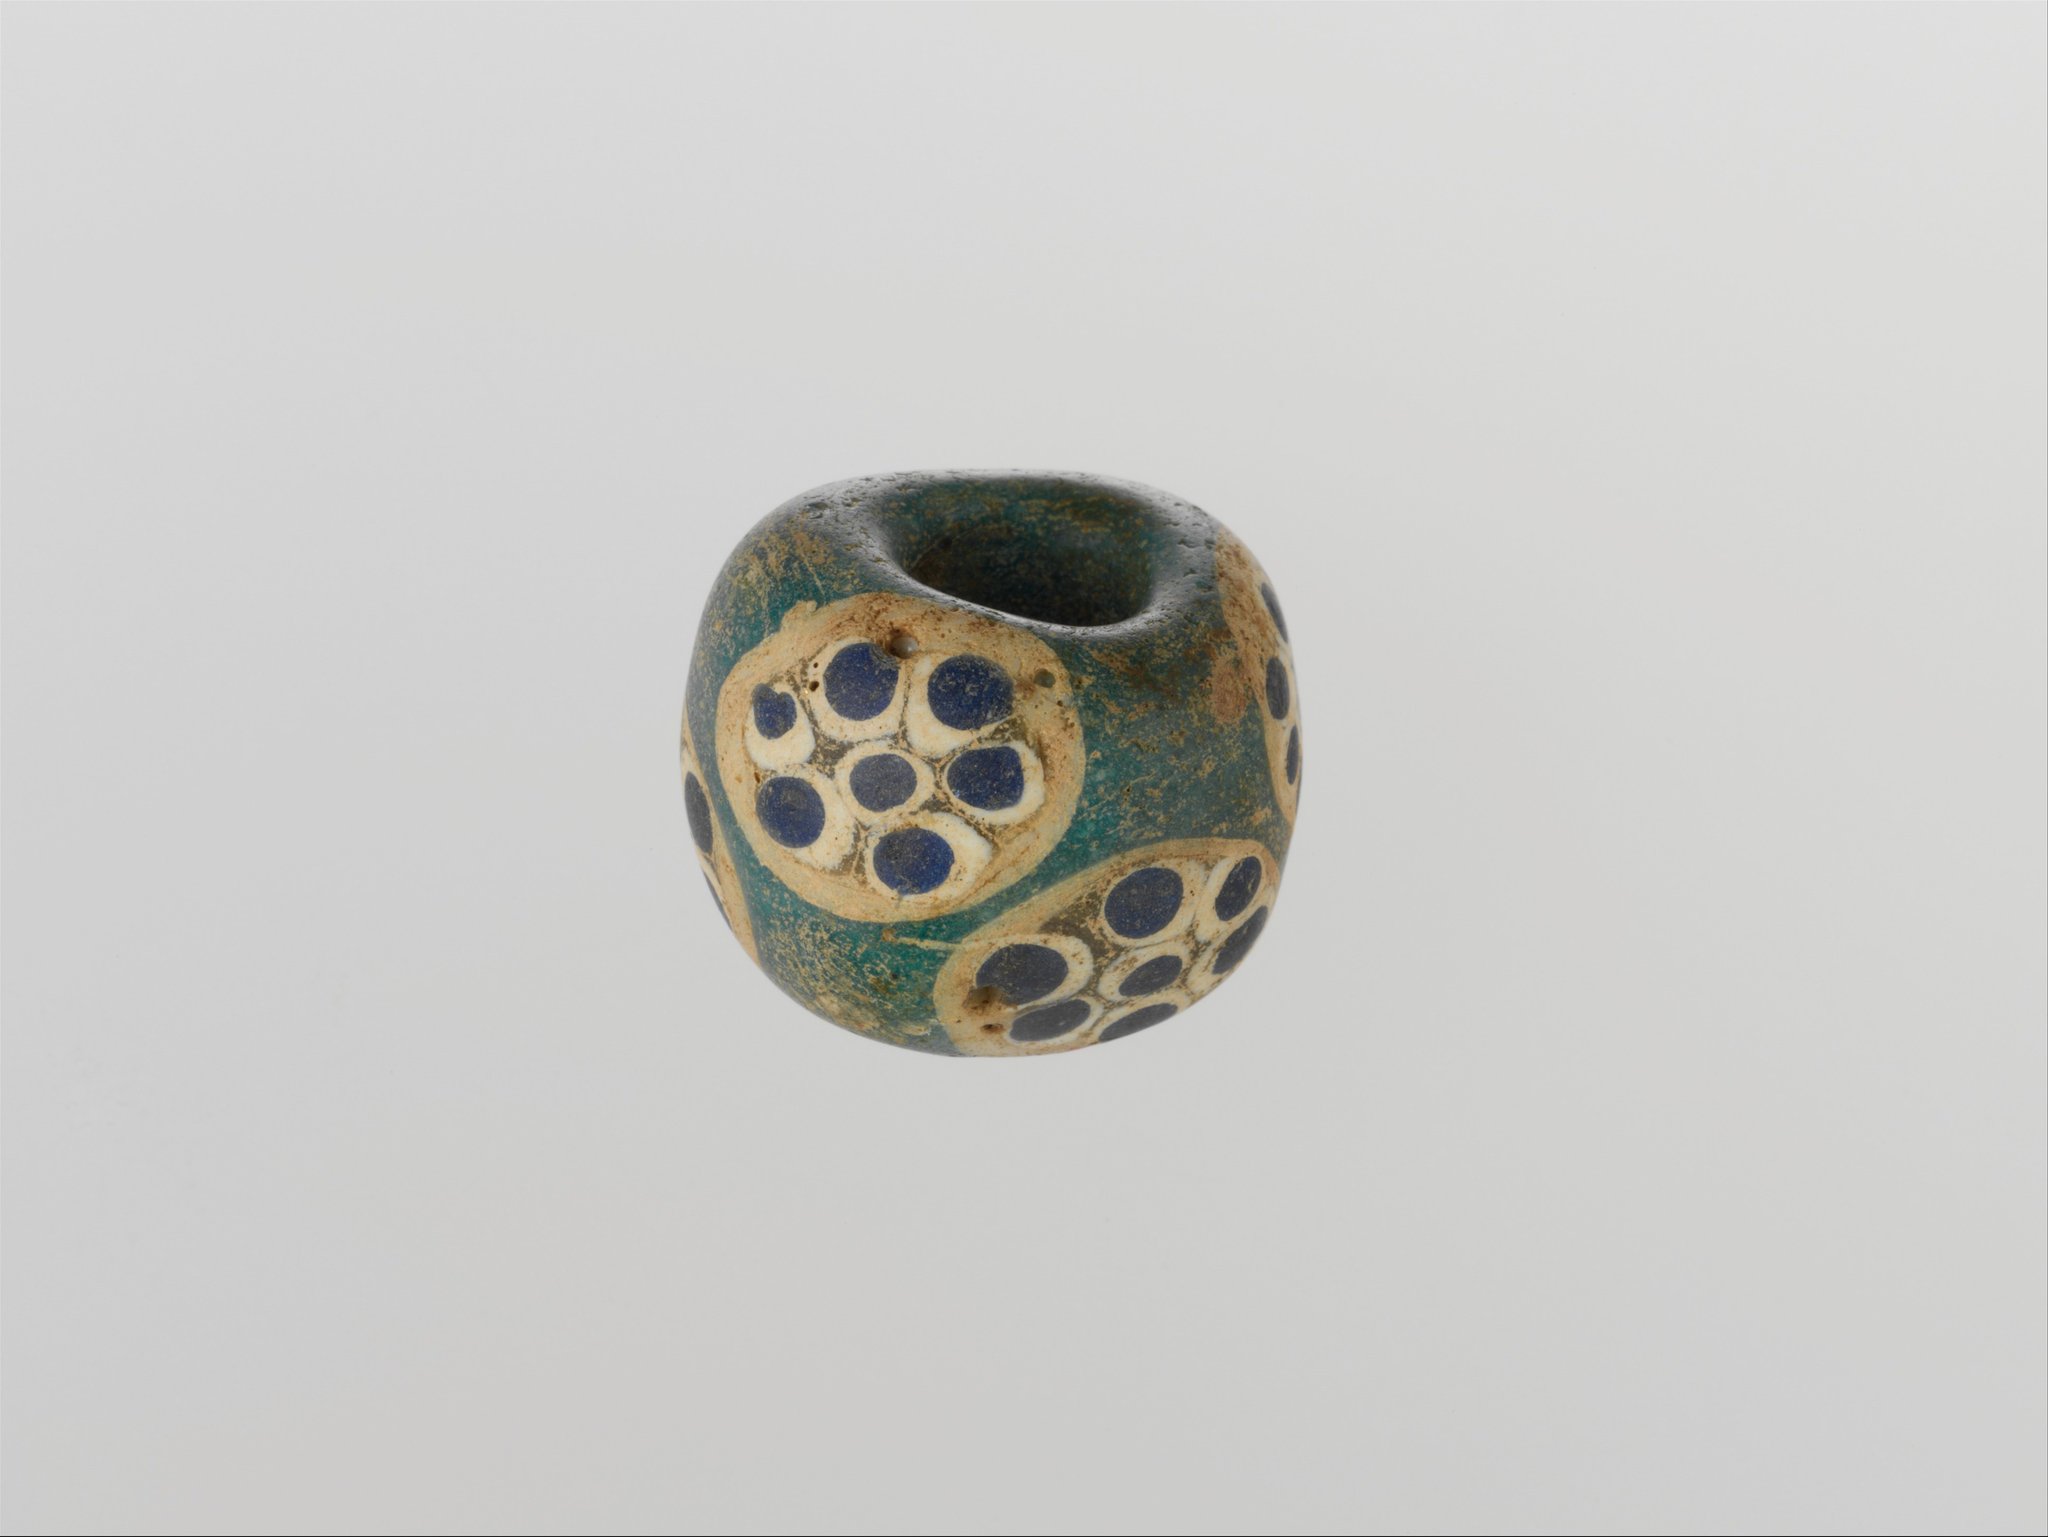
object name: bead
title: Glass compound eye bead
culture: greek, eastern mediterranean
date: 400-301 BCE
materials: glass